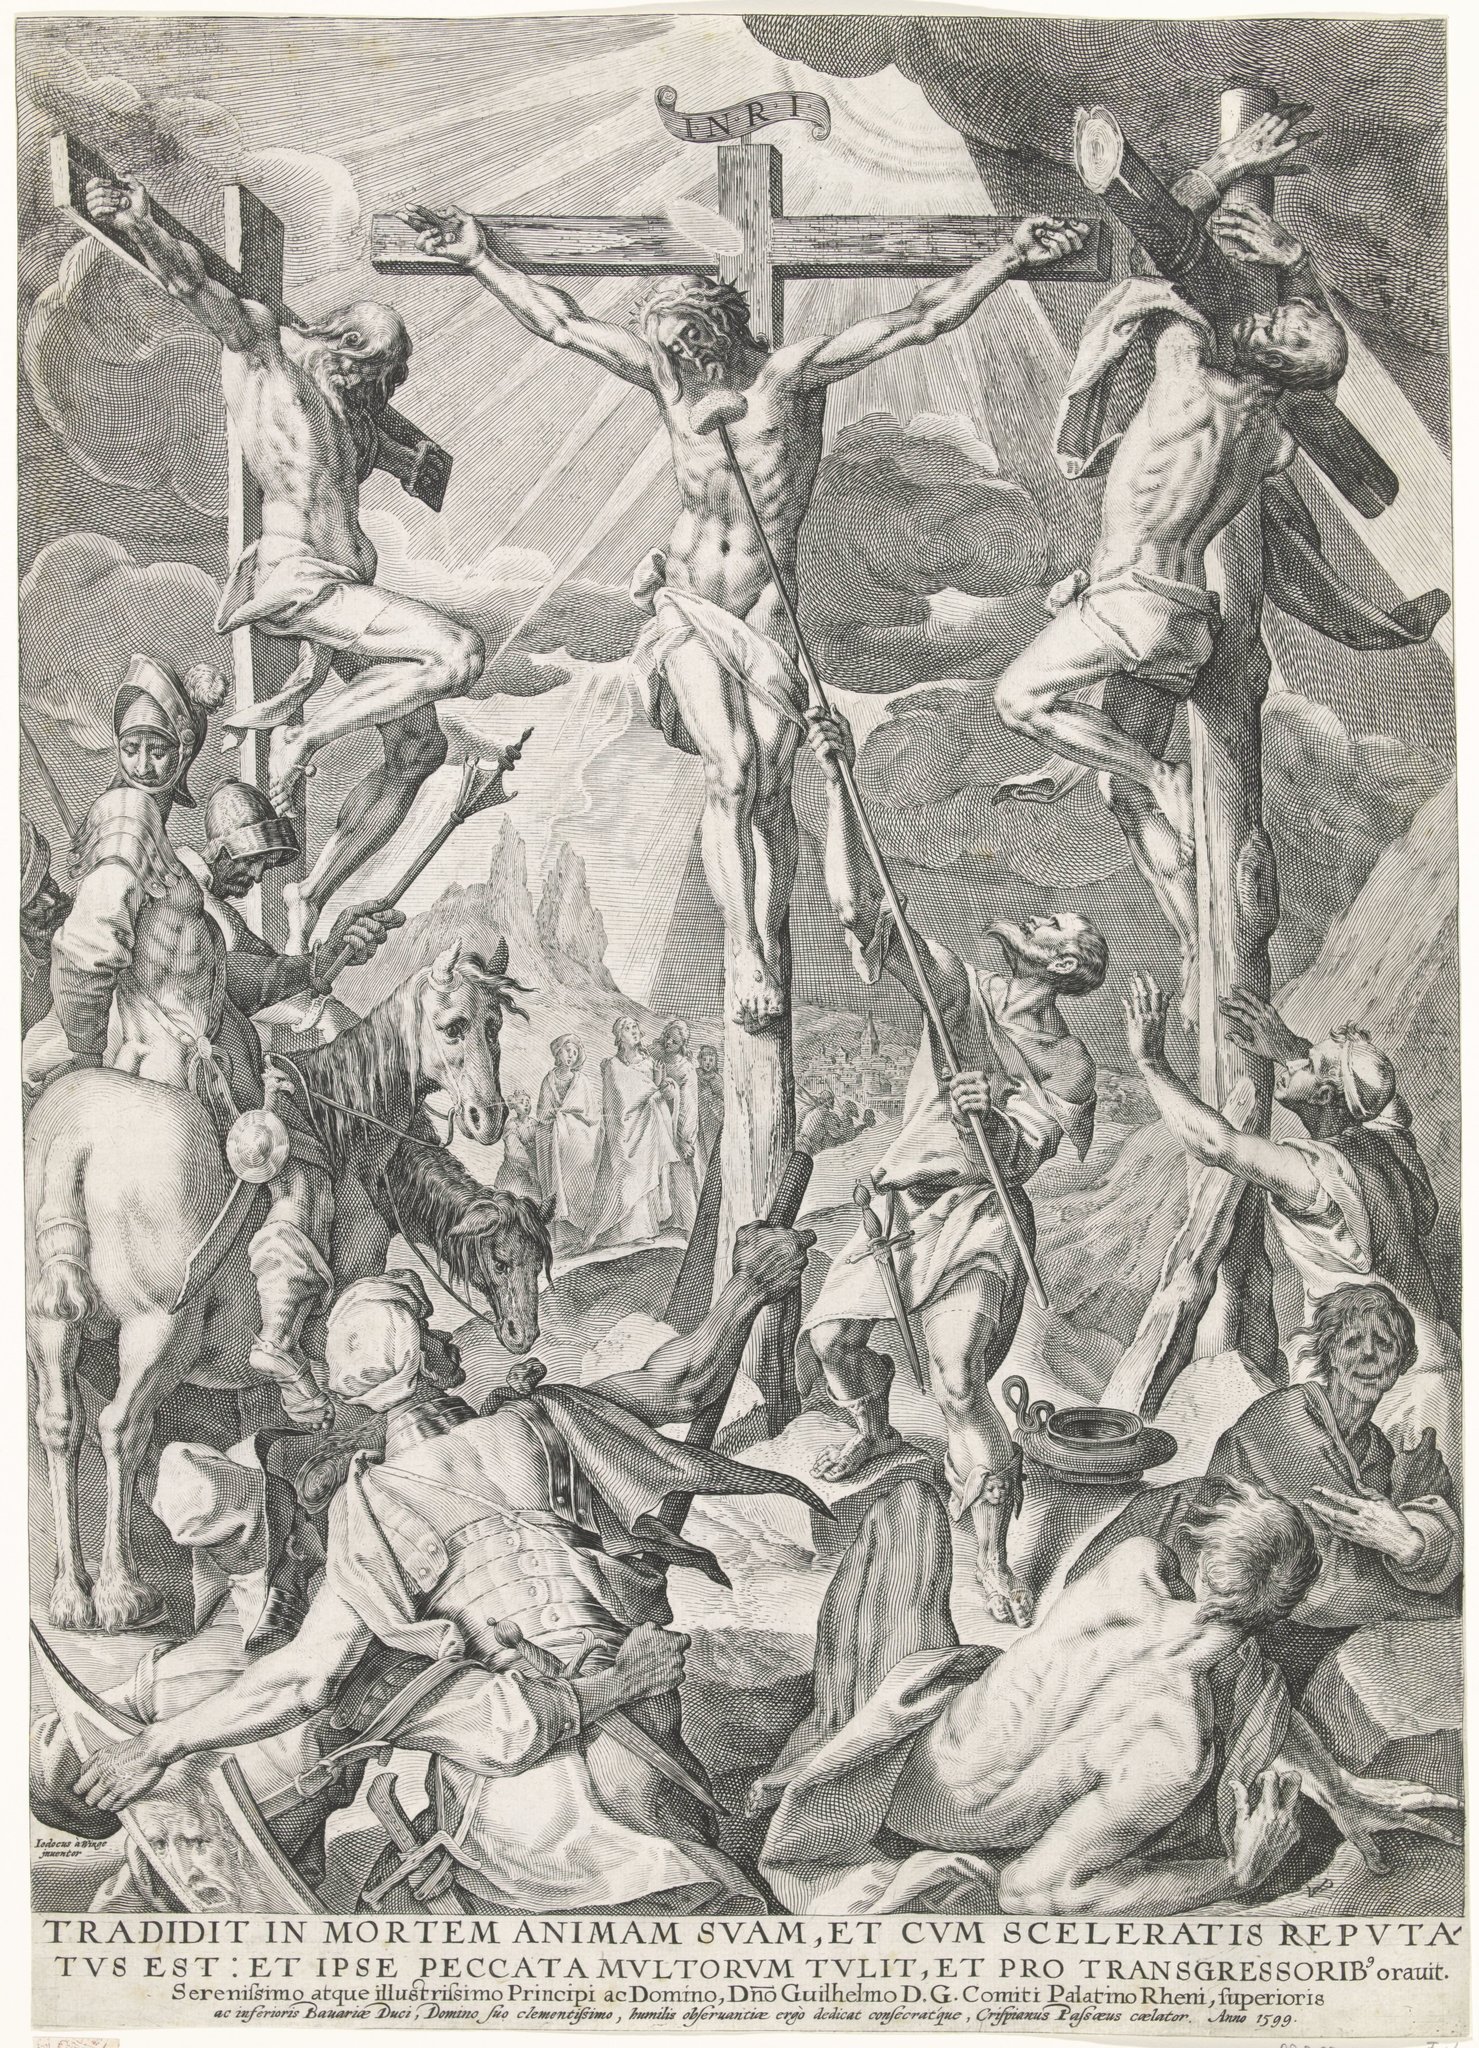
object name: print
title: Kruisiging van Christus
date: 1599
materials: paper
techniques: engraving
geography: cologne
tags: the crucifixion of christ: christ's death on the cross; golgotha (matthew 27:45-58; mark 15:33-45; luke 23:44-52; john 19:25-38)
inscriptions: date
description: De kruisdood van Christus op de berg Golgota. Links en rechts van hem de misdadigers die samen met hem gekruisigd zijn. Stefaton houdt de spons voor het gezicht van Christus. Op de voorgrond diverse omstanders en toeschouwers. Op de achtergrond bevinden zich Maria Magdalena, Maria en de Heilige Johannes. In de marge een vierregelig onderschrift, met een opdracht, in het Latijn.